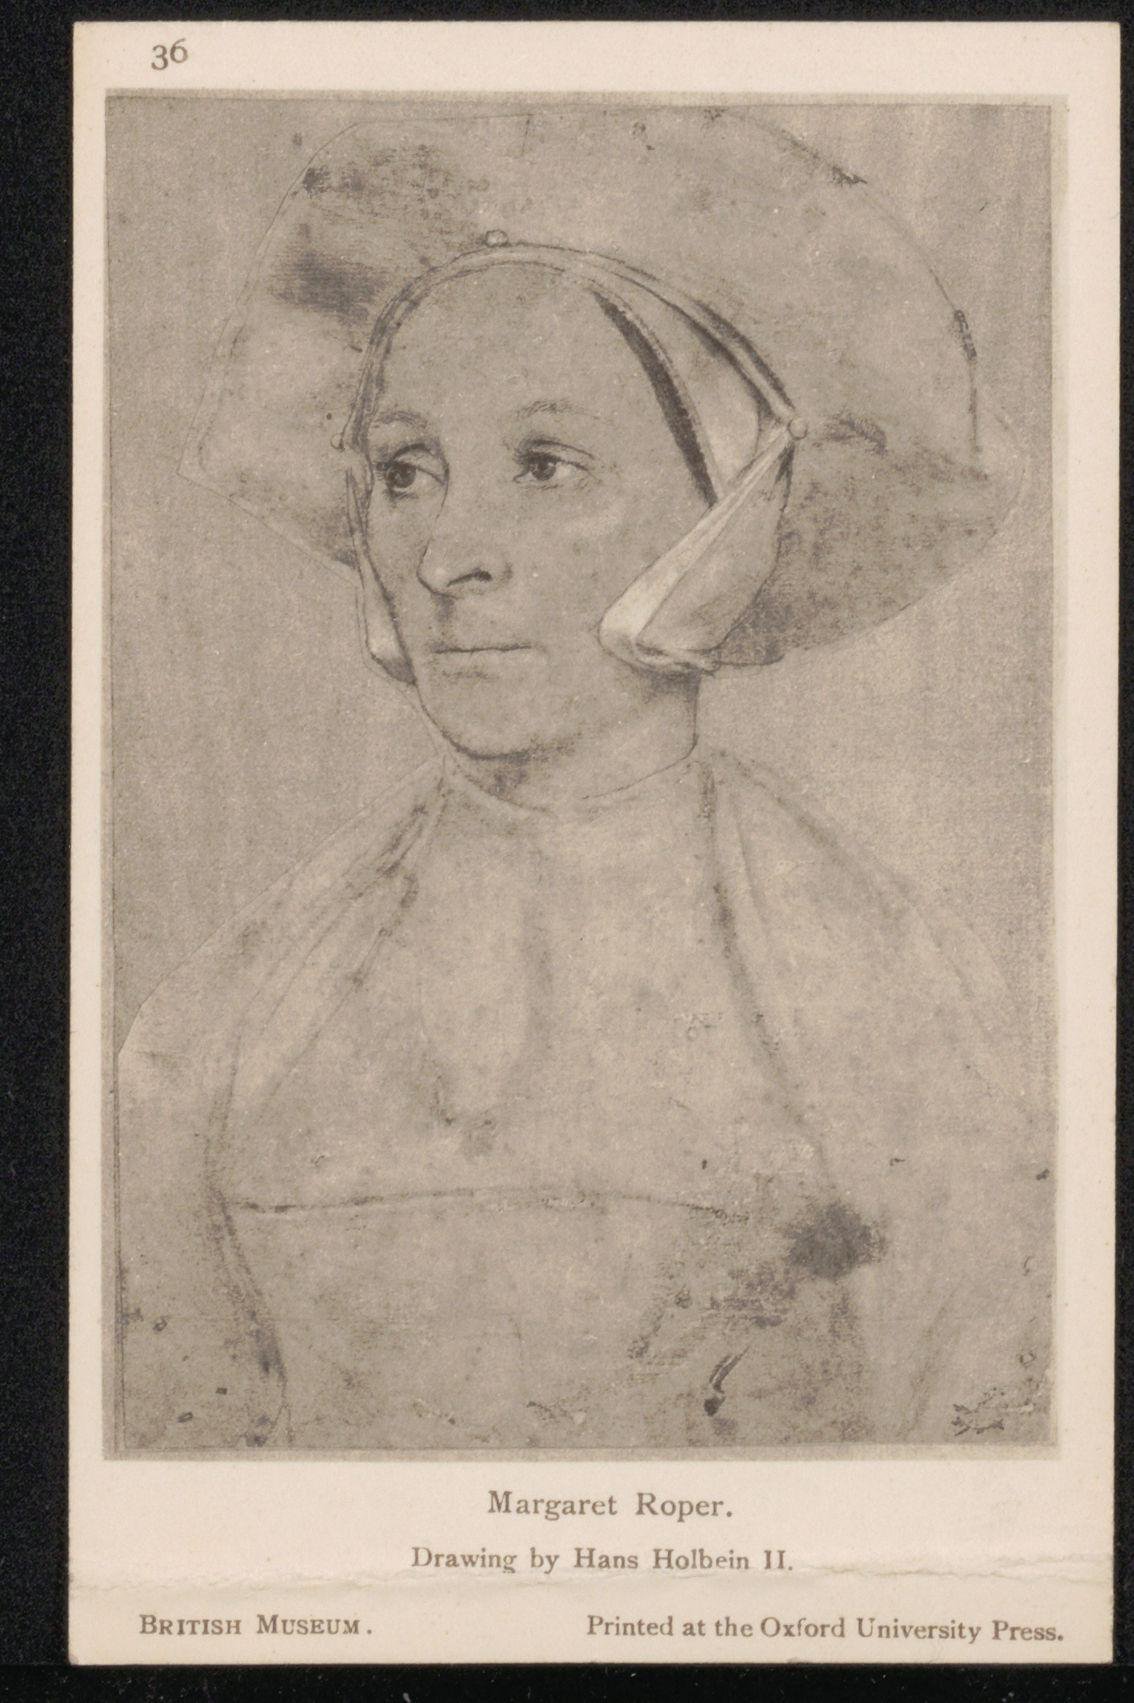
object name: ansichtkaart, prentbriefkaart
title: Prentbriefkaart aan Willem Bogtman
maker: richard nicolaüs roland holst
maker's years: 1868-1938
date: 1892-1938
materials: cardboard, ink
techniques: pen, photoaquatint, writing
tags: haarlem, willem bogtman